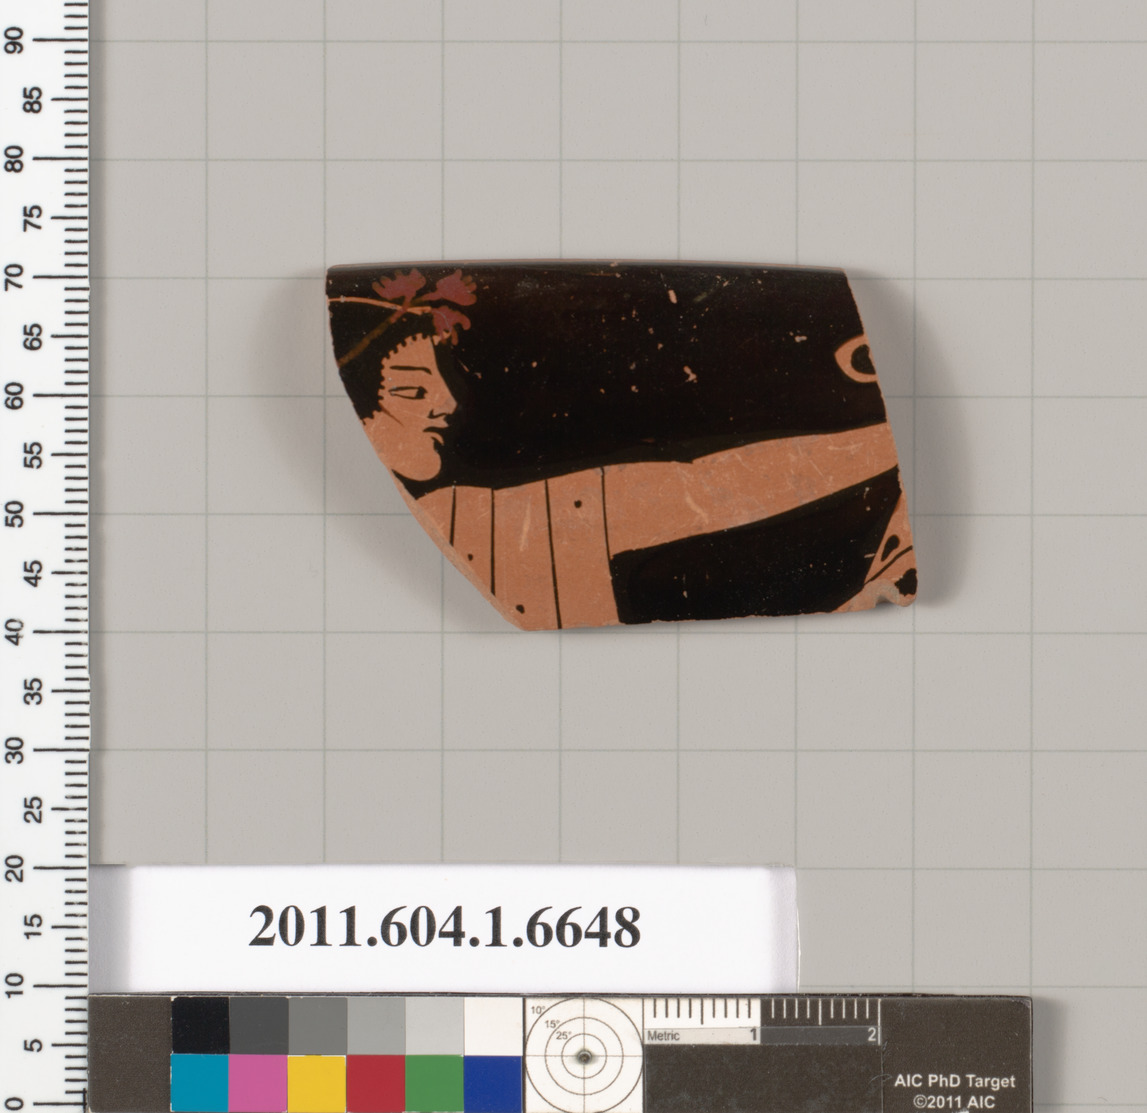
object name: kylix fragment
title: Terracotta rim fragment of a kylix (drinking cup)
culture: greek, attic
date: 490-470 BCE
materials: terracotta